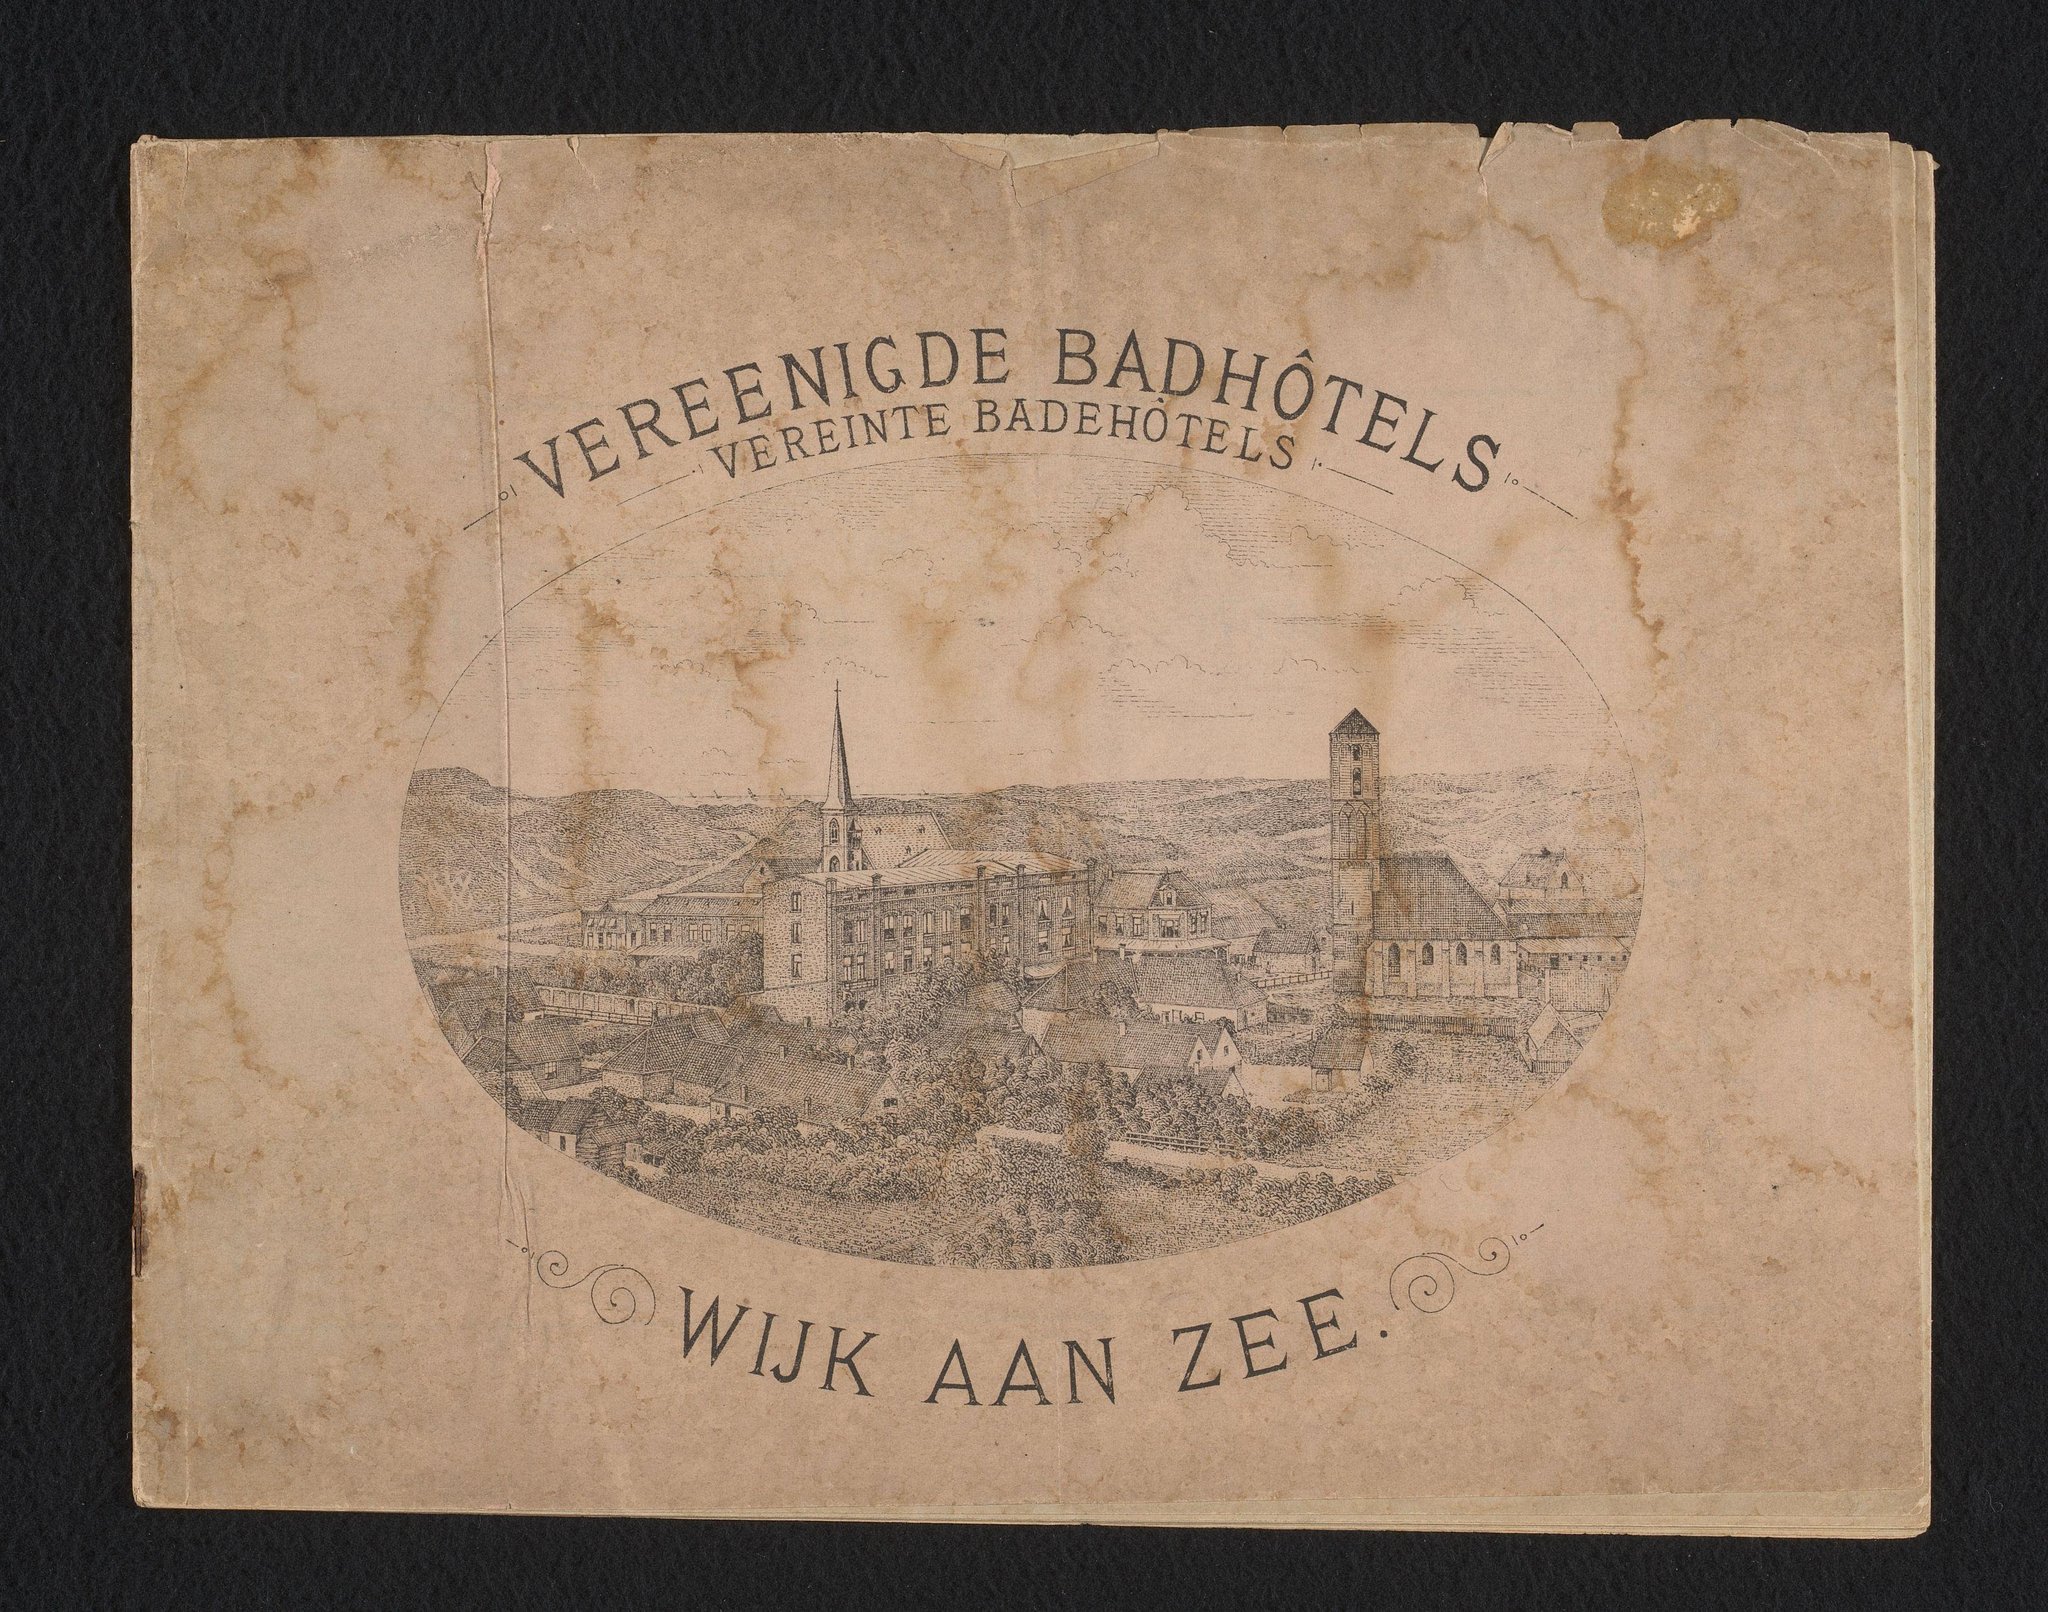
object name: book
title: Badplaatsen en bezienswaardigheden bij Wijk aan Zee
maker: Anonymous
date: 1893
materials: paper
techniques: letterpress printing, lithograph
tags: city-view, and landscape with man-made constructions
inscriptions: collector's mark: ‘Vosmaer’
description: Boek met informatie over diverse (bad)plaatsen bij Wijk aan Zee. Het werk is geïllustreerd met gezichten op de omgeving van Wijk aan Zee. Op de omslag staat in een ovaal een stadsgezicht afgebeeld. Rondom staat de titel.